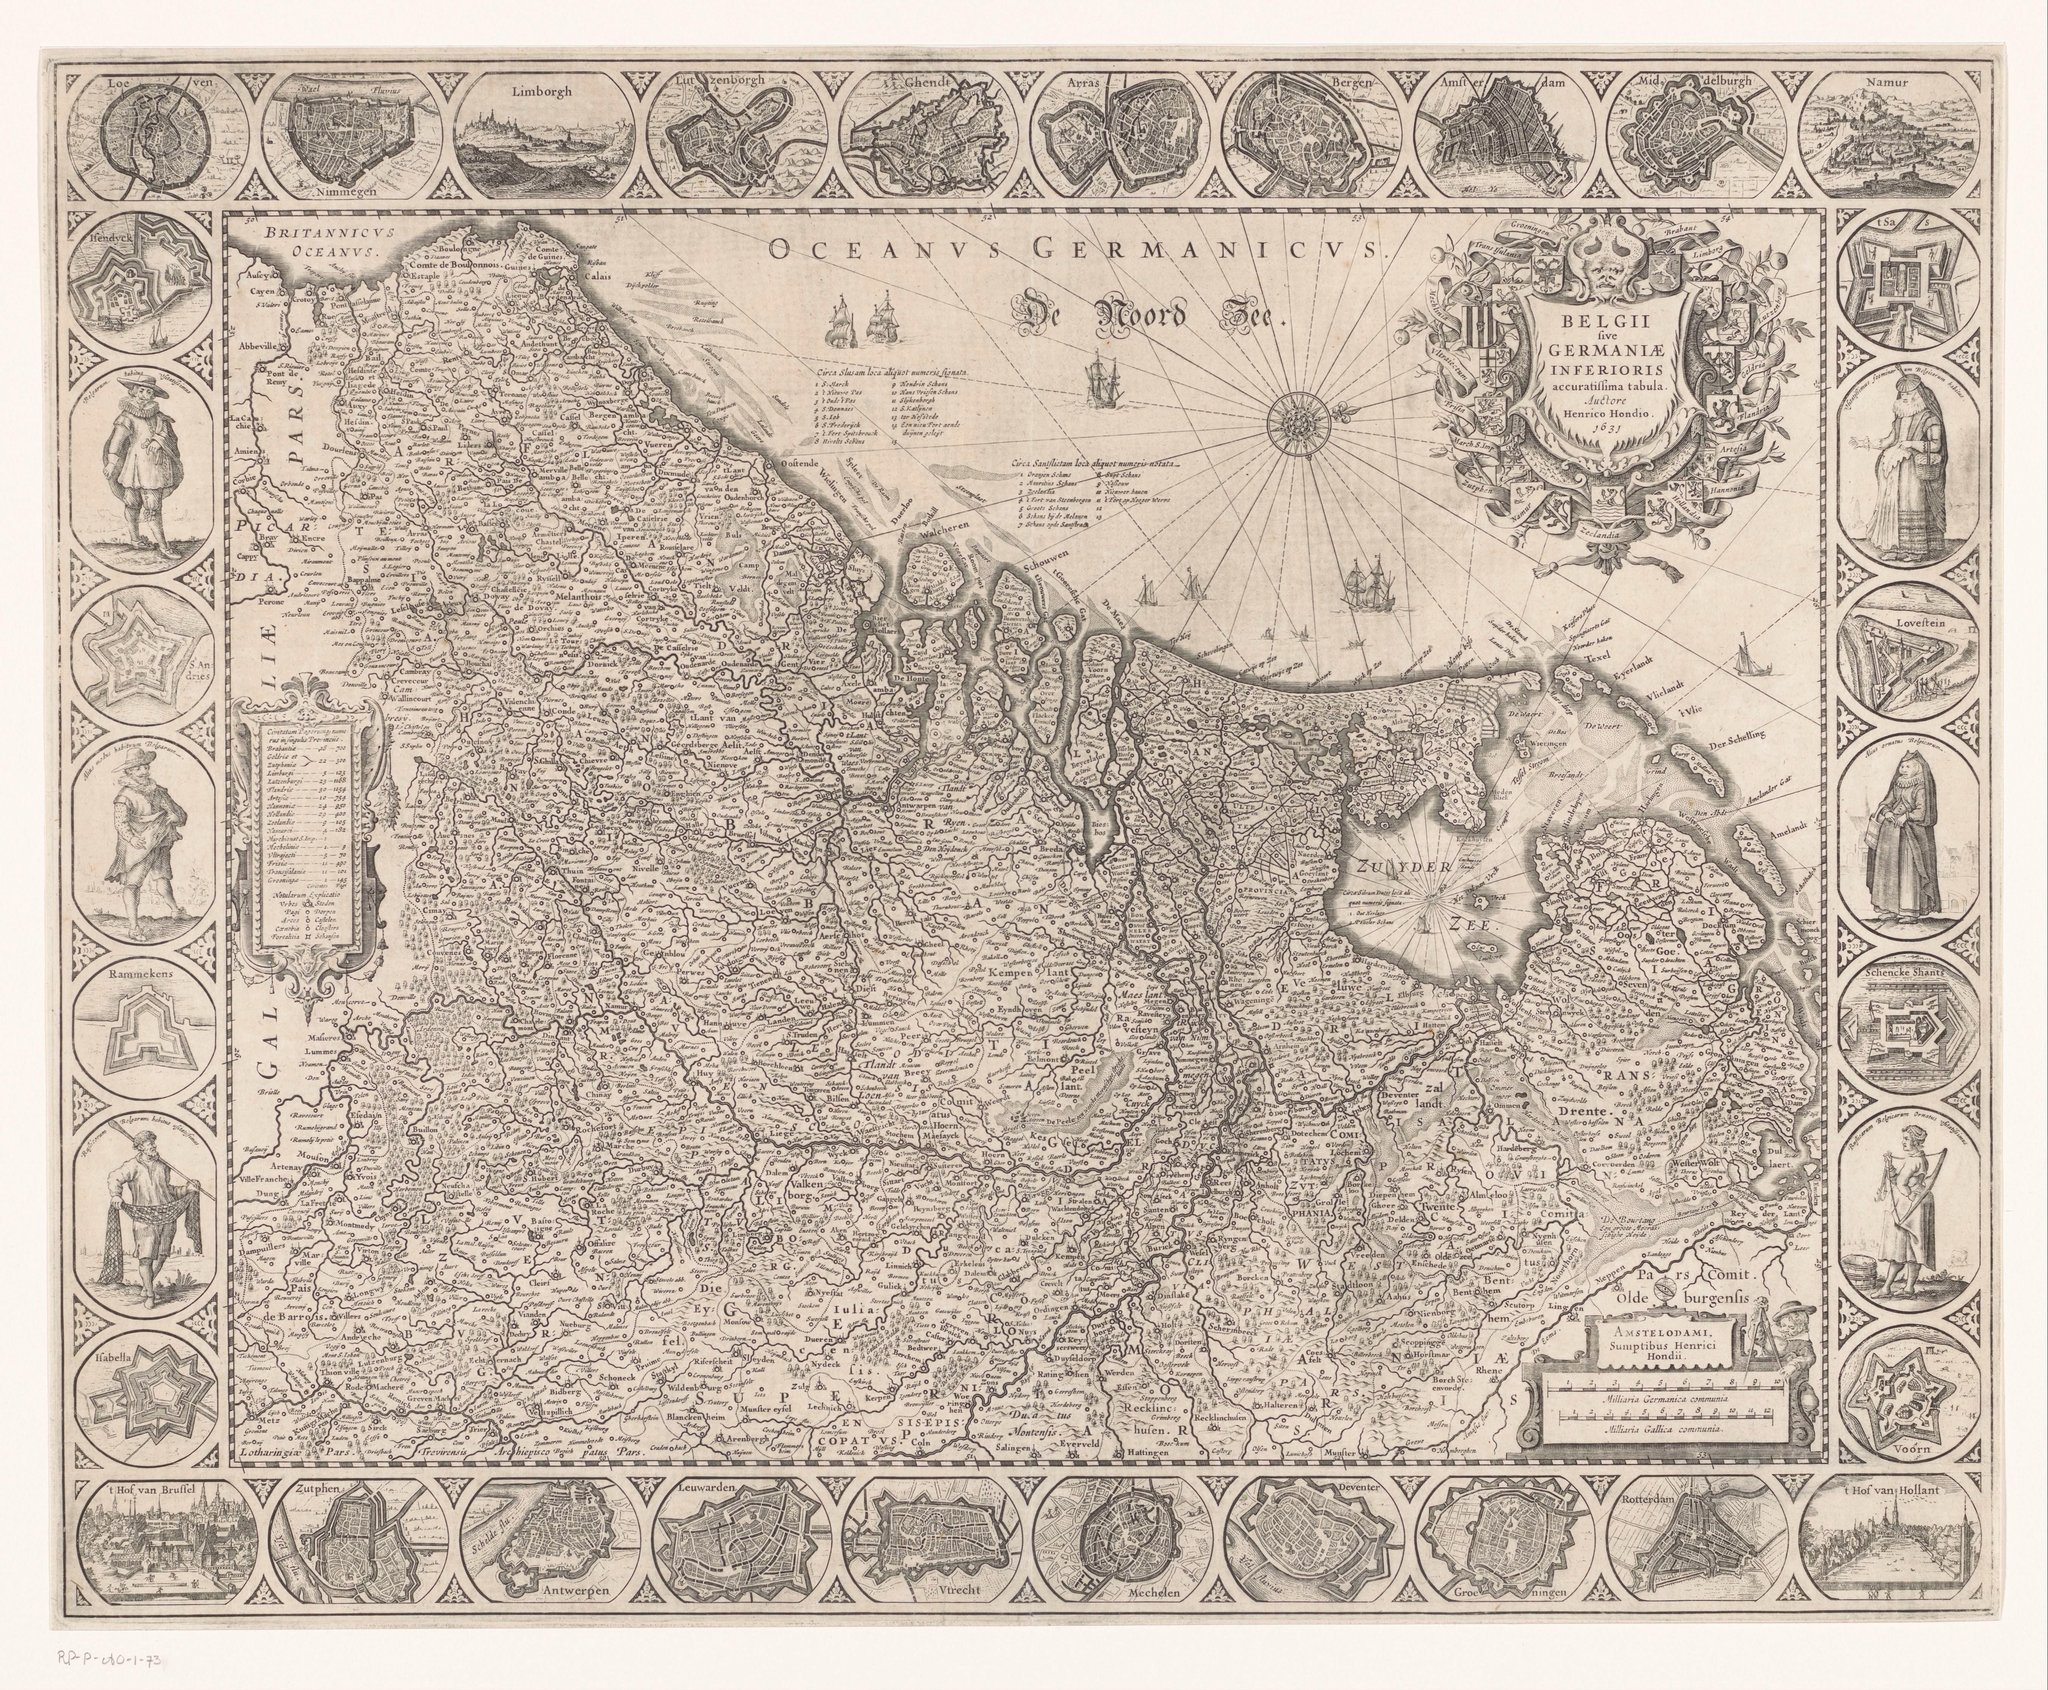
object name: print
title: Kaart van de Nederlanden, 1631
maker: henricus hondius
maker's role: print maker, publisher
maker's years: 1597-1651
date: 1631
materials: paper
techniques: engraving, etching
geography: amsterdam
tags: coat of arms (as symbol of the state, etc.), maps of separate countries or regions, folk costume, regional costume, the hague, antwerp, mechelen, middelburg, rotterdam, ghent, brussels, utrecht, deventer, nijmegen, low countries, amsterdam, louvain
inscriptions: date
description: Links een cartouche met een overzicht met topografische informatie over iedere provincie. Rechtsboven titelcartouche in de vorm van een schild omringd door de wapens van de Zeventien Provinciën. Rechtsonder cartouche met schaalstok: Milliaria Germanica communia, Milliaria Gallica communia. Gradenverdeling langs de randen. In het randwerk plattegronden van de belangrijkste steden en forten en zes medaillons met klederdrachten van Nederlandse mannen en vrouwen, burgers en boeren. Met alle opschriften in het Latijn. Oriëntatie: noorden rechts.